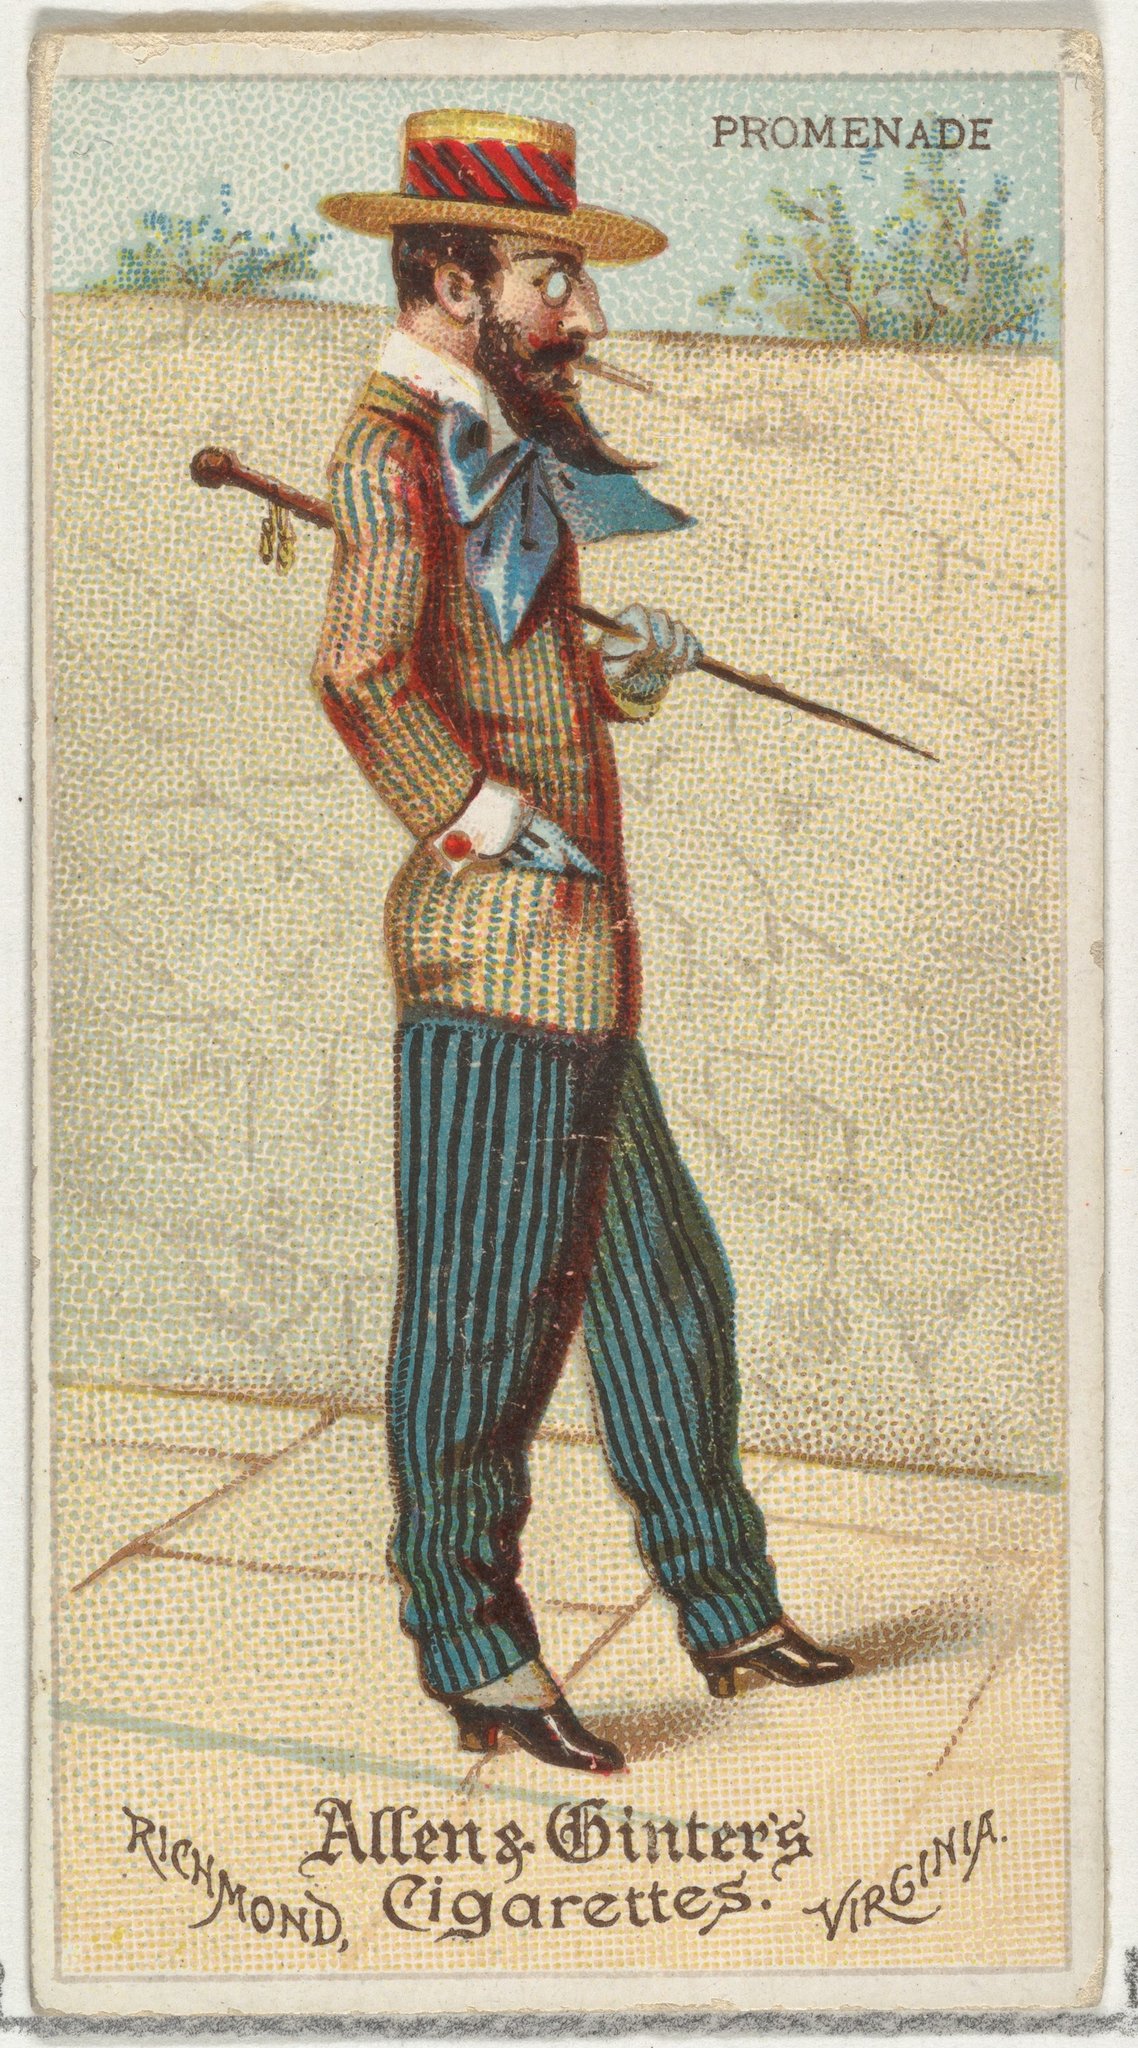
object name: print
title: Promenade, from World's Dudes series (N31) for Allen & Ginter Cigarettes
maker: allen & ginter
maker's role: publisher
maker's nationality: american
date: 1888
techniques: color lithograph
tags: men,profiles